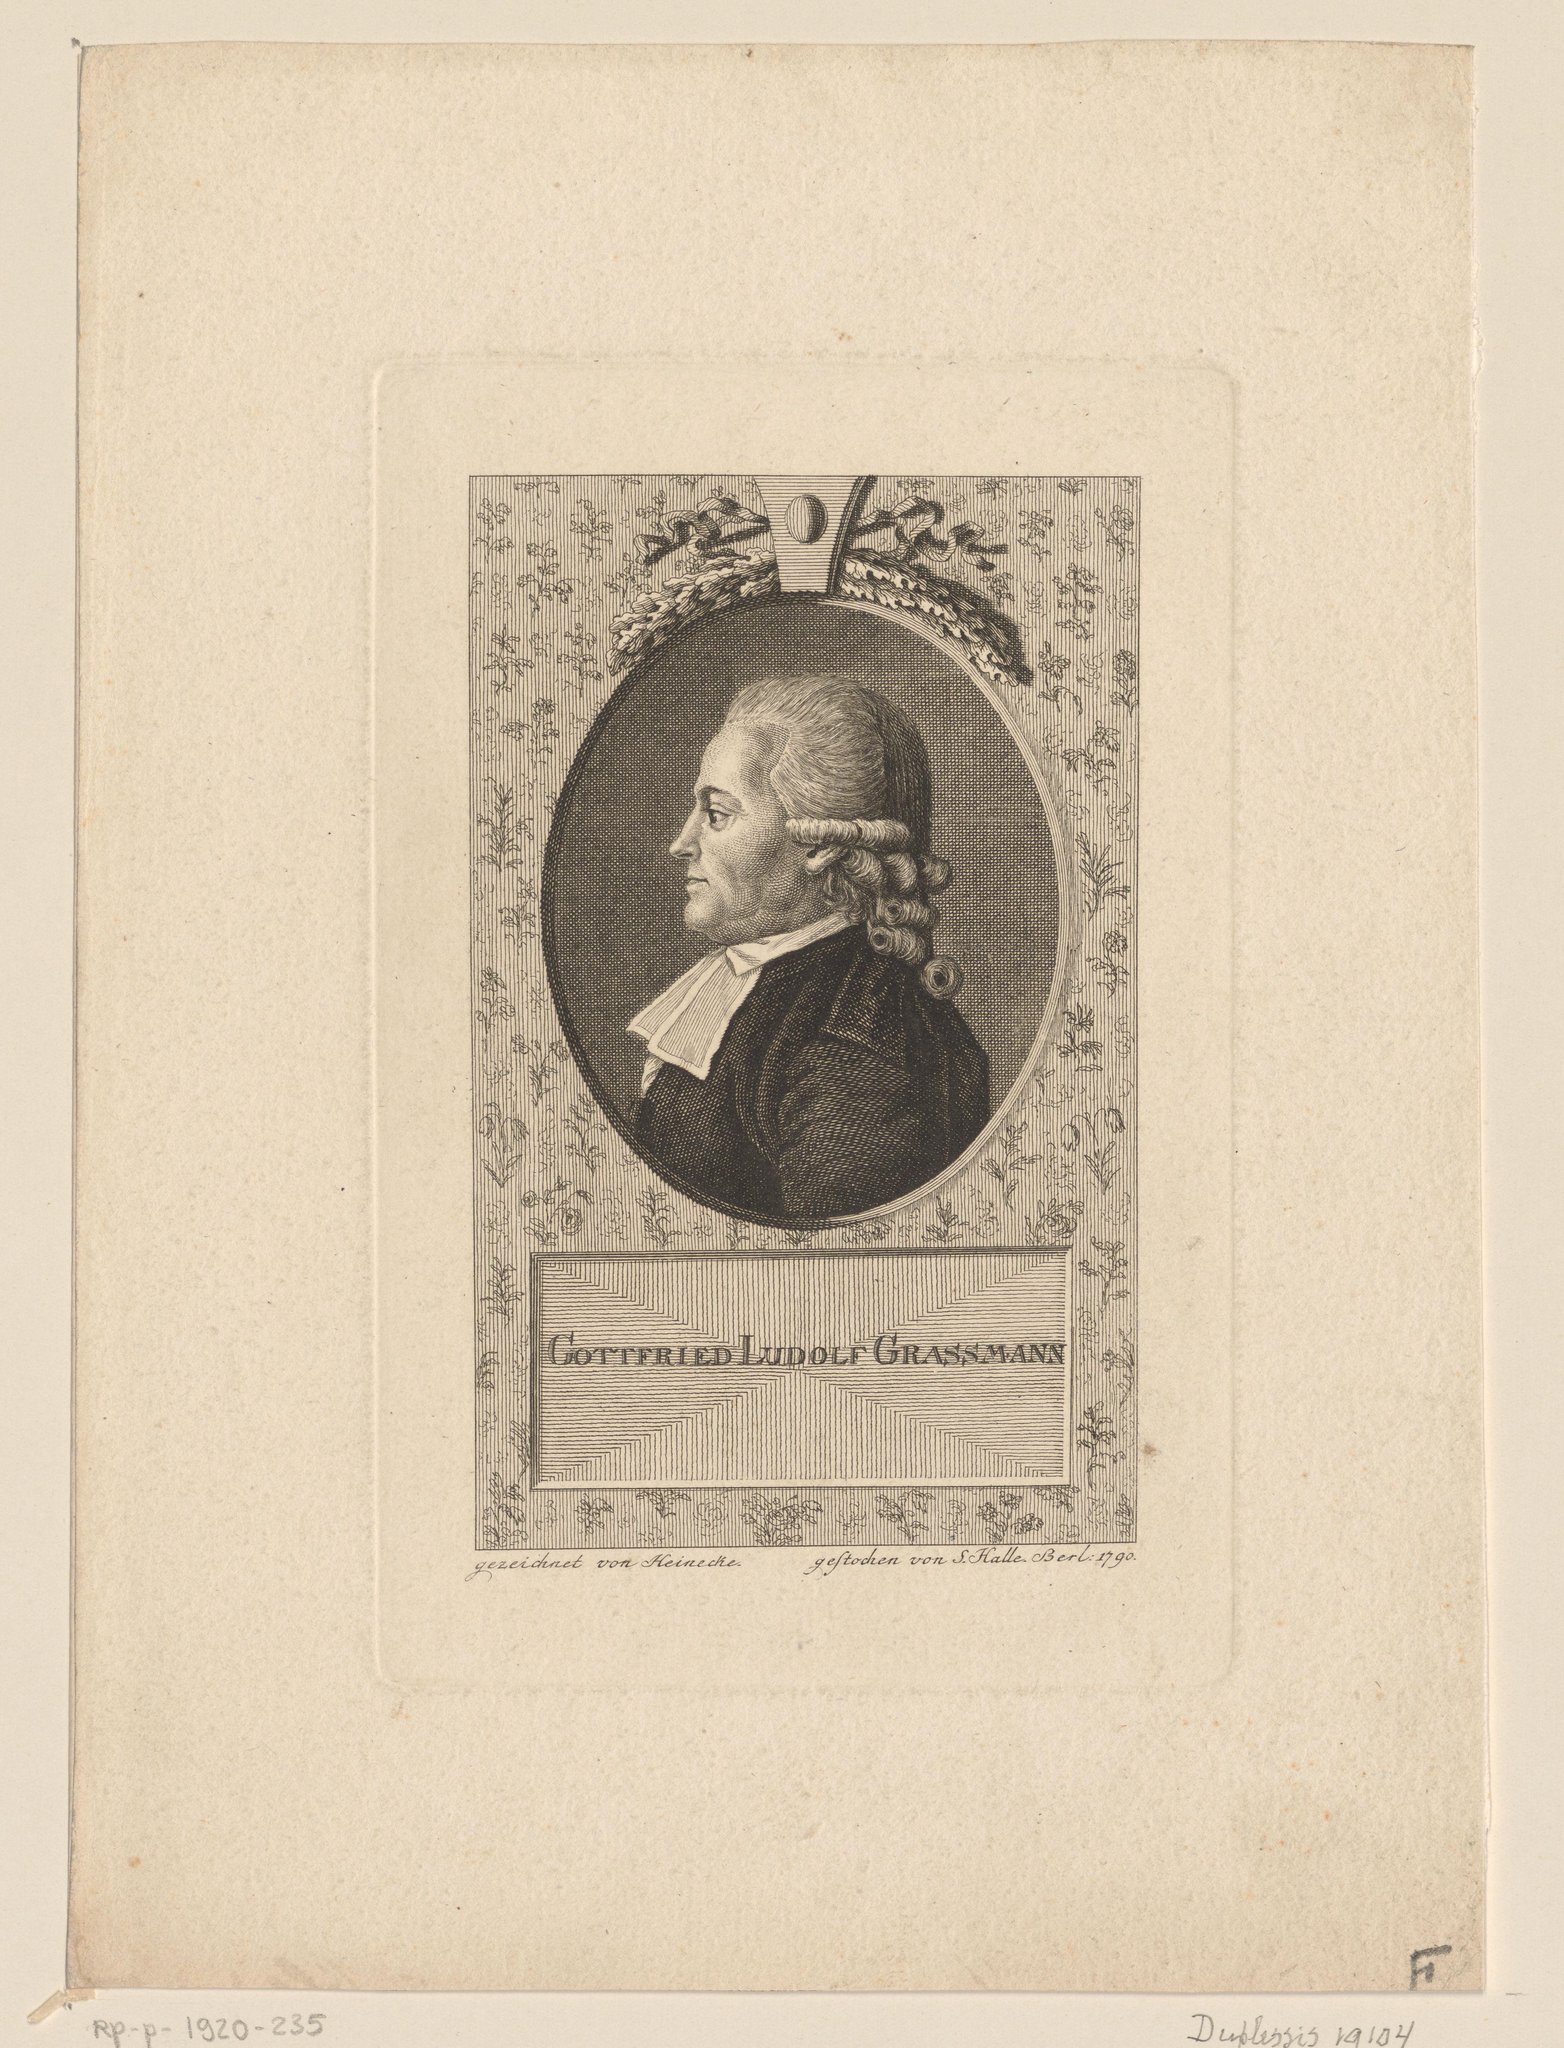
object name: print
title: Portret van Gottfried Ludolf Grassmann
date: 1790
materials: paper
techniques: engraving, etching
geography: berlin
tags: ornament ~ medallion, historical persons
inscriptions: collector's mark: Lugt 2228